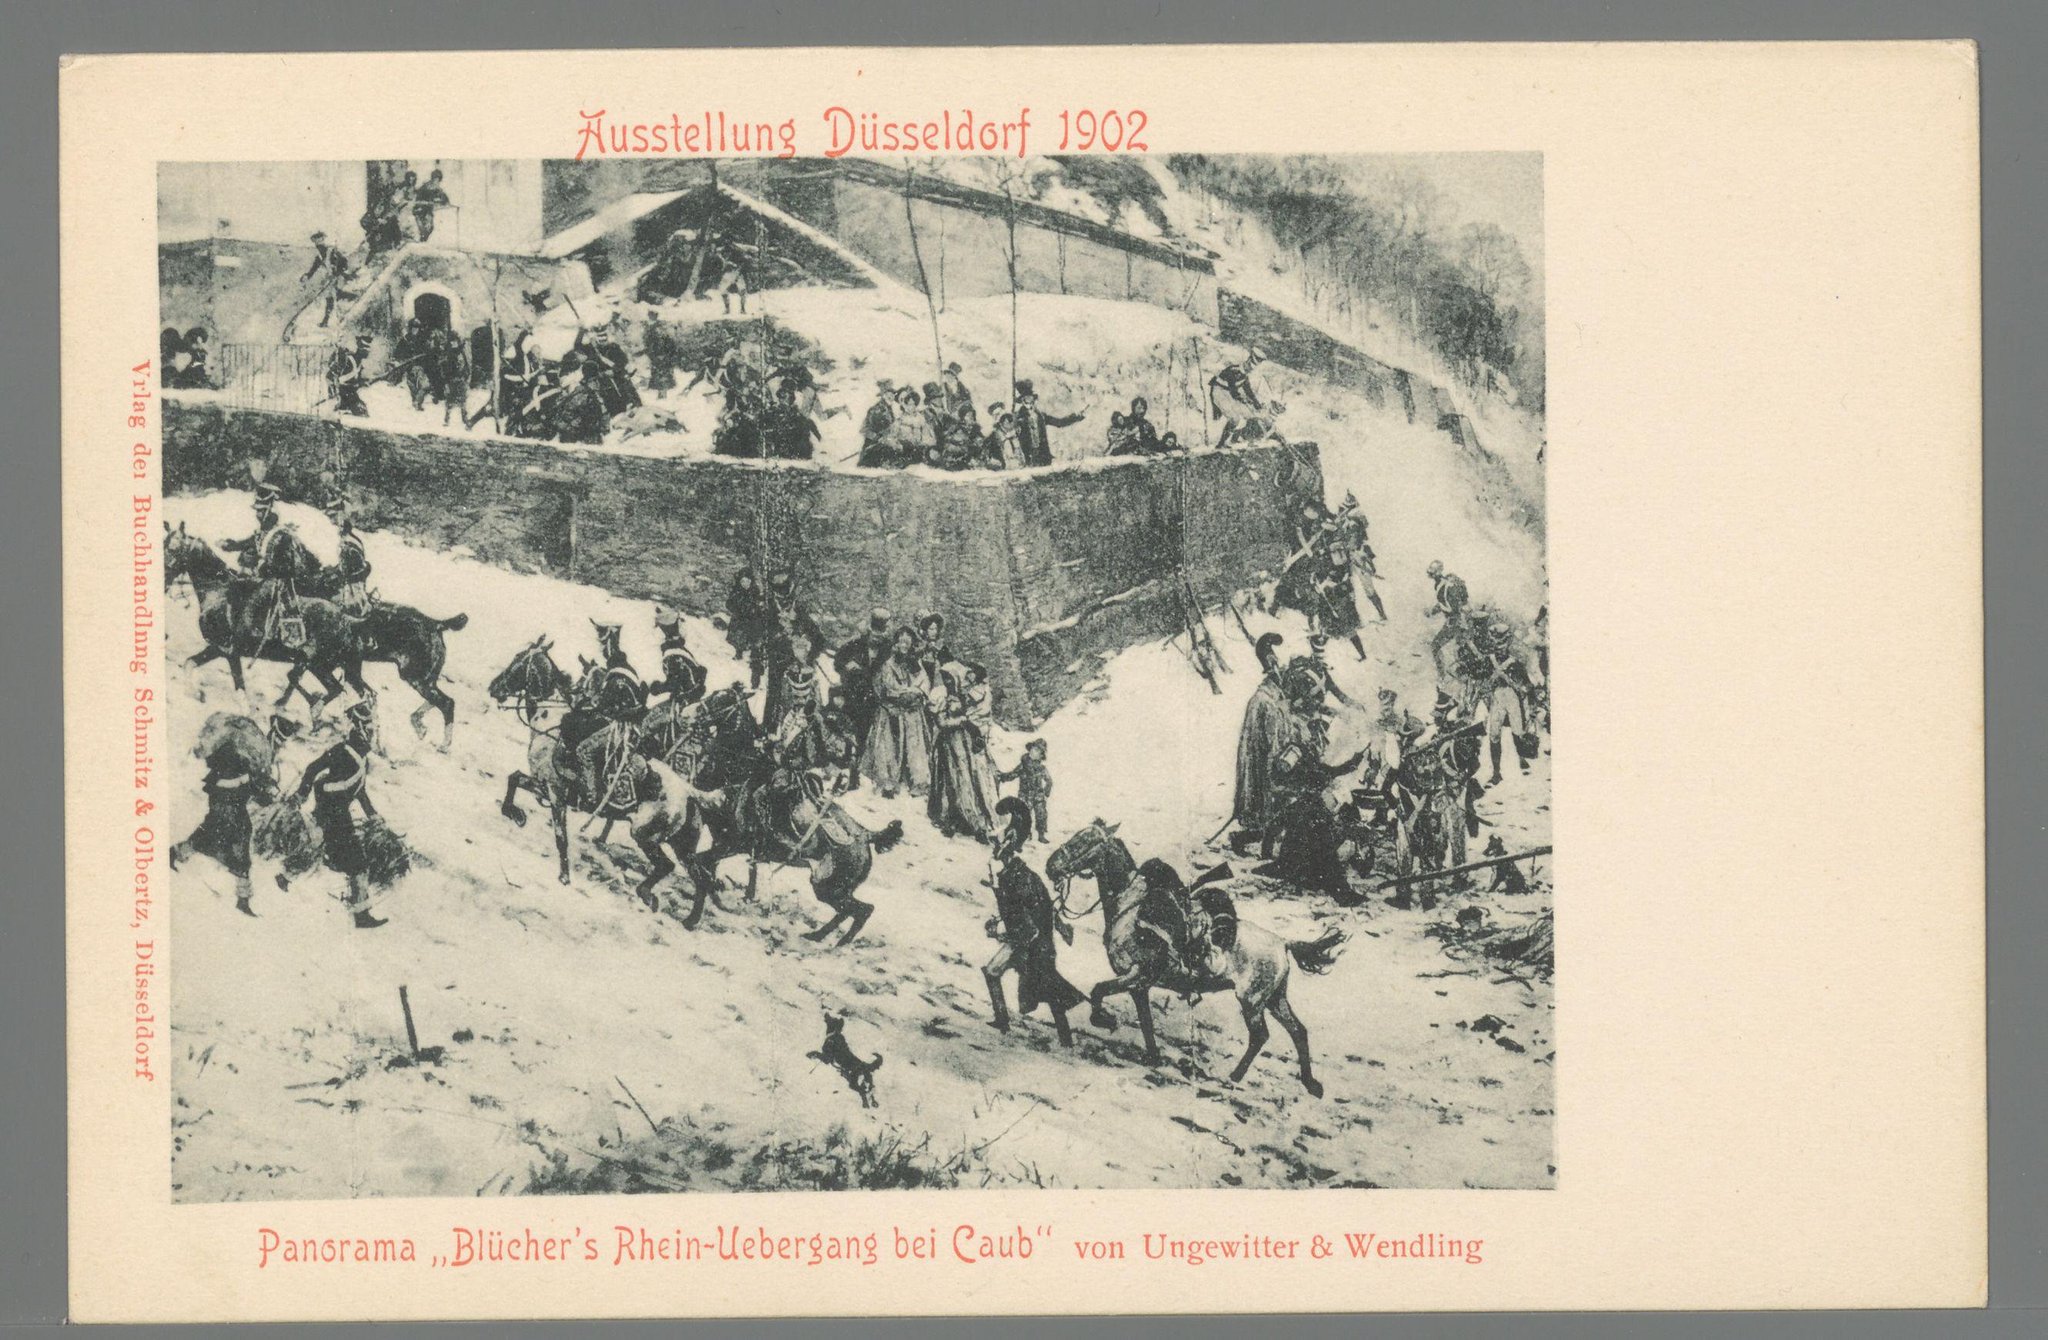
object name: reproduction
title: Ausstellung Düsseldorf 1902. Panorama "Blücher's Rhein-Uebergang bei Caub" von Ungewitter & Wending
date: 1902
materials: cardboard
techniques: photograph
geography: dusseldorf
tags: army 'en route', temporary exhibition, 'salon'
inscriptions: date